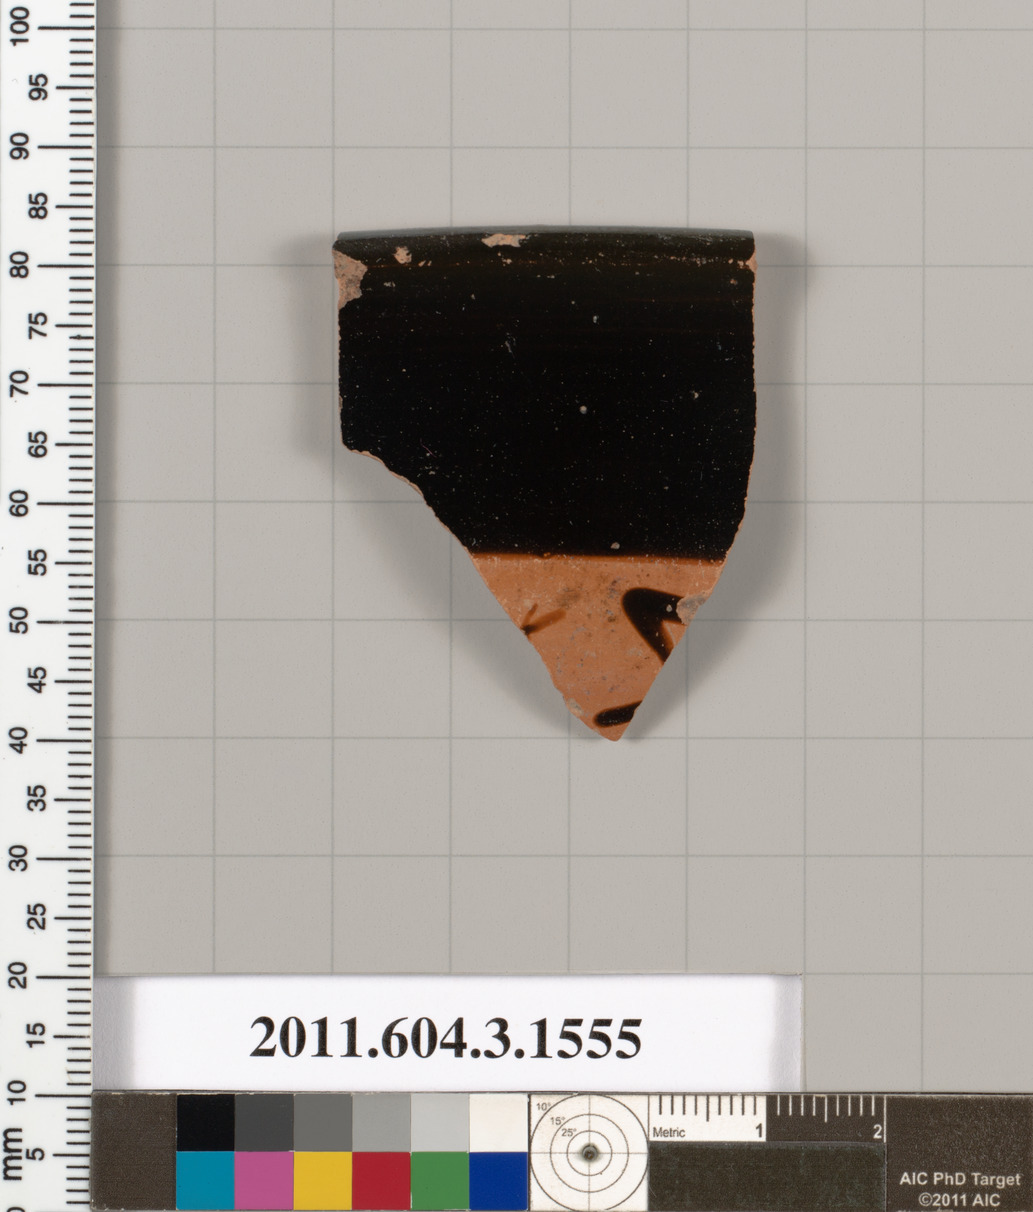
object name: kylix fragment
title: Terracotta rim fragment of a kylix: Band cup (drinking cup)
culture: greek, attic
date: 567-535 BCE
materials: terracotta